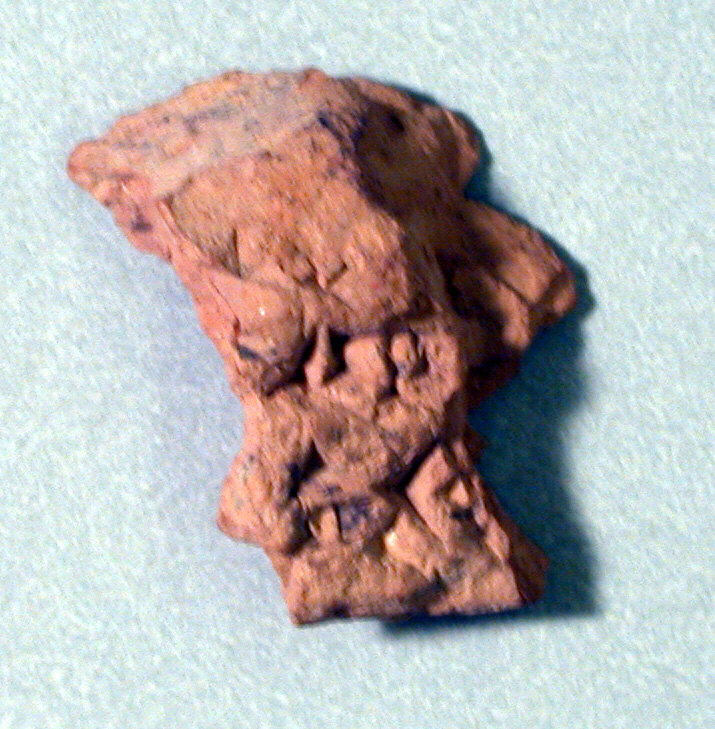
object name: cuneiform tablet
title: Cuneiform tablet: fragment, content uncertain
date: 333-1 BCE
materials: clay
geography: mesopotamia